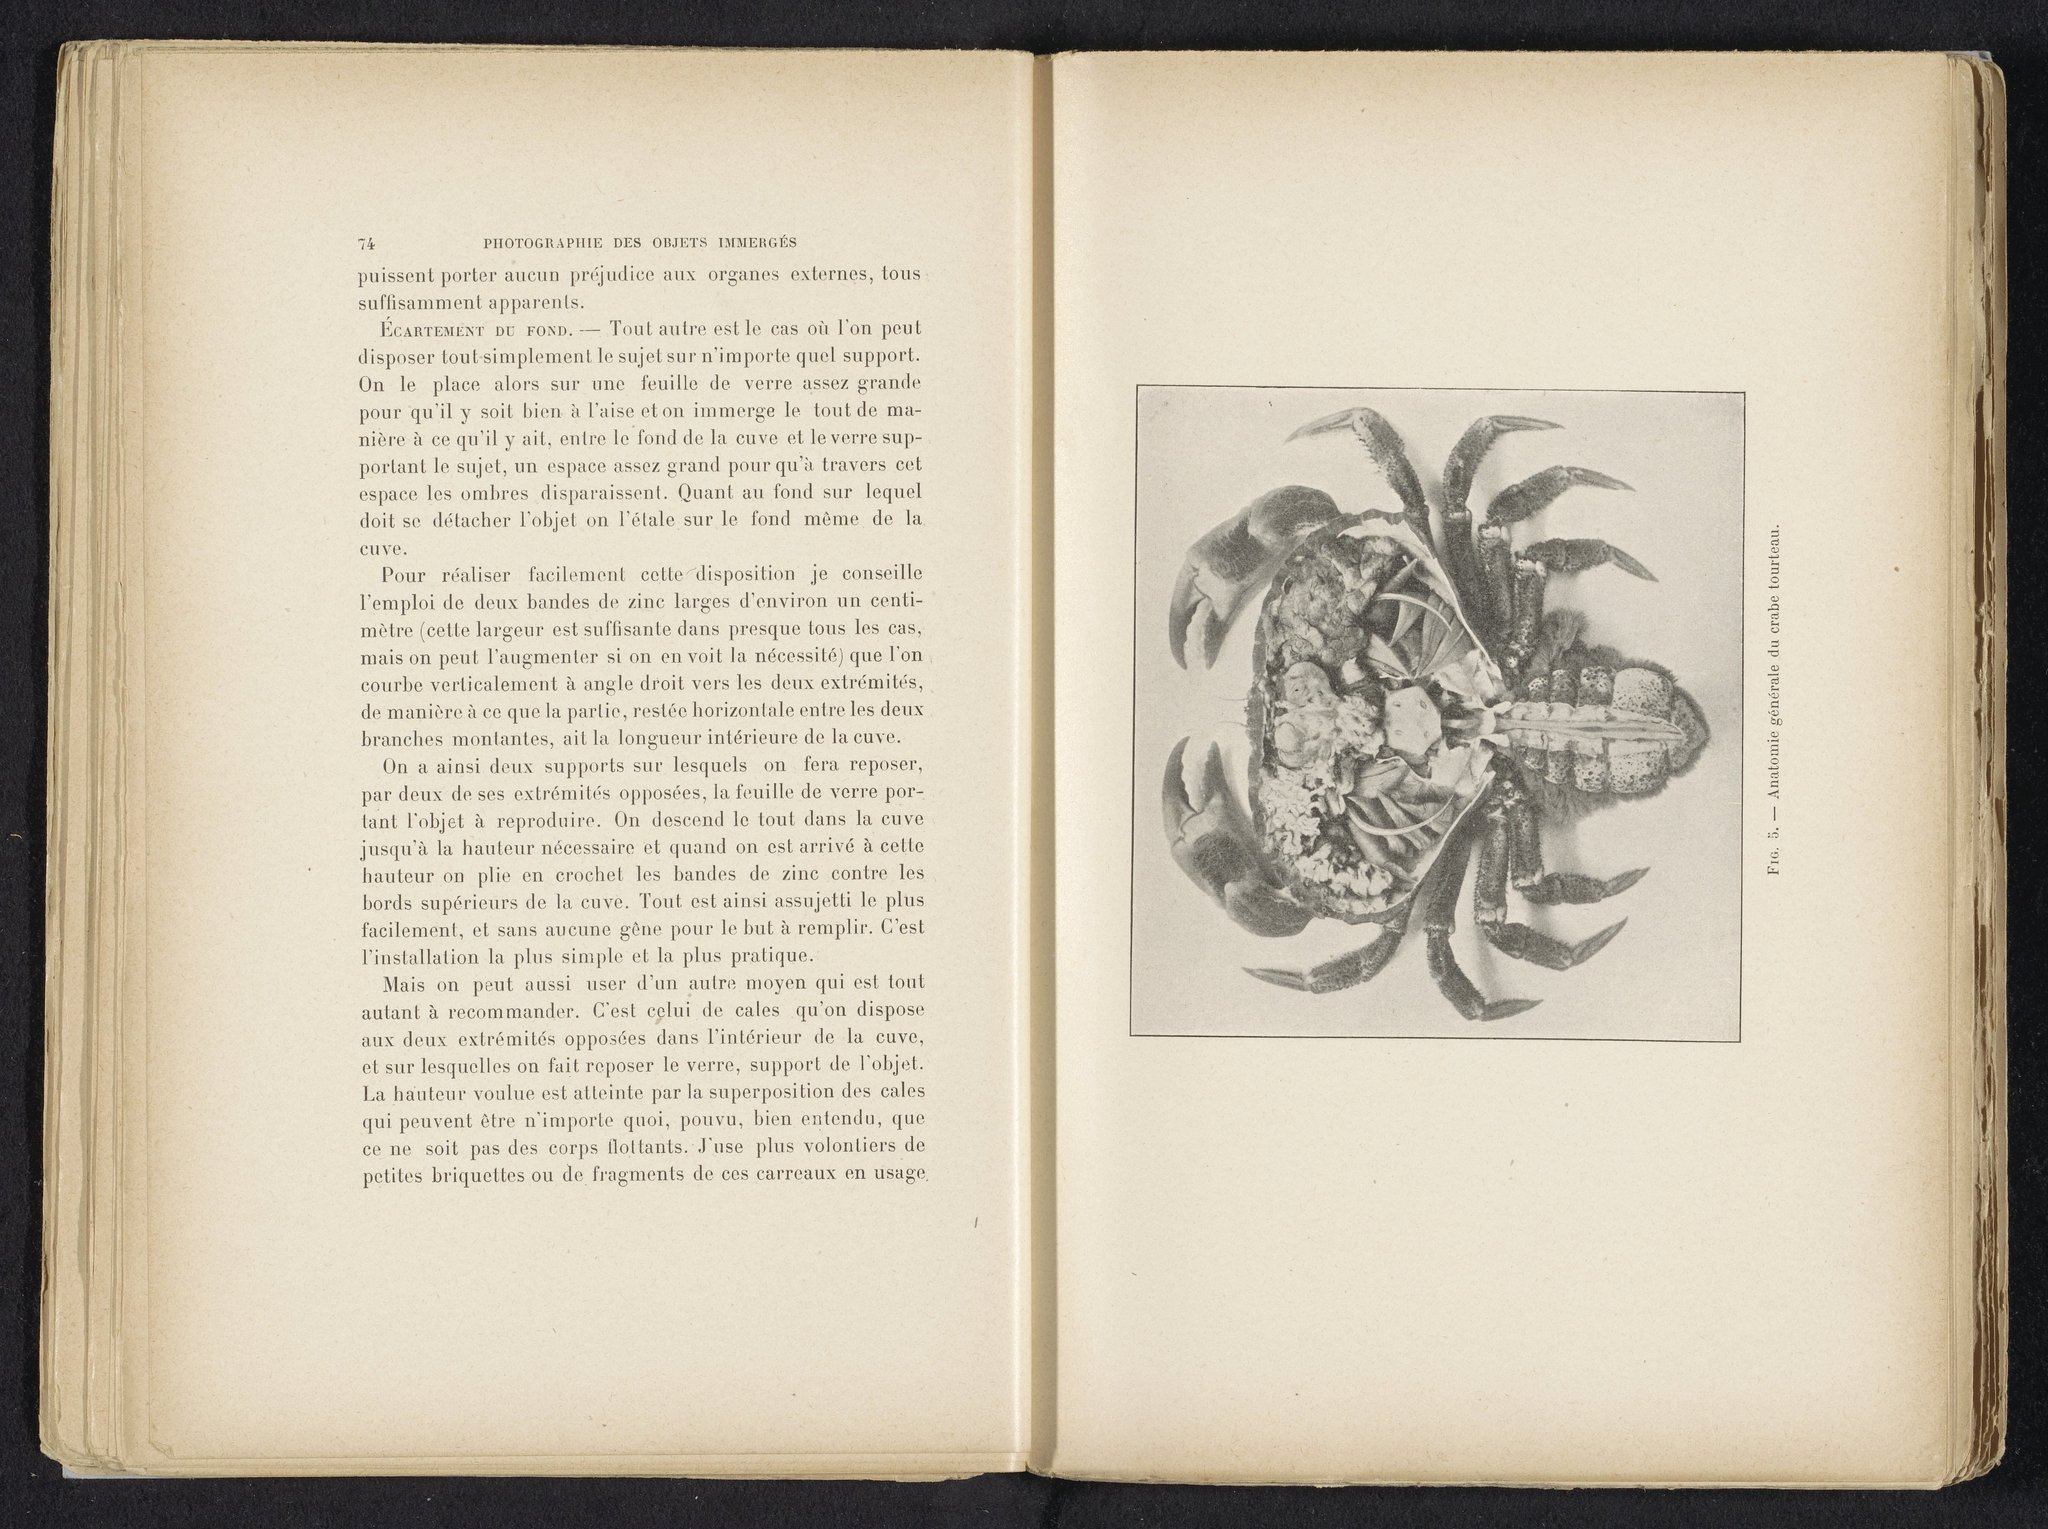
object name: photomechanical print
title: Opengesneden noordzeekrab met de organen zichtbaar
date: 1891-1901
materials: paper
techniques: autotype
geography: paris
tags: crustaceans: crab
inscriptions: number: ‘Fig. 5.’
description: Prent in album 'La photographie des objets immergés', 1901.